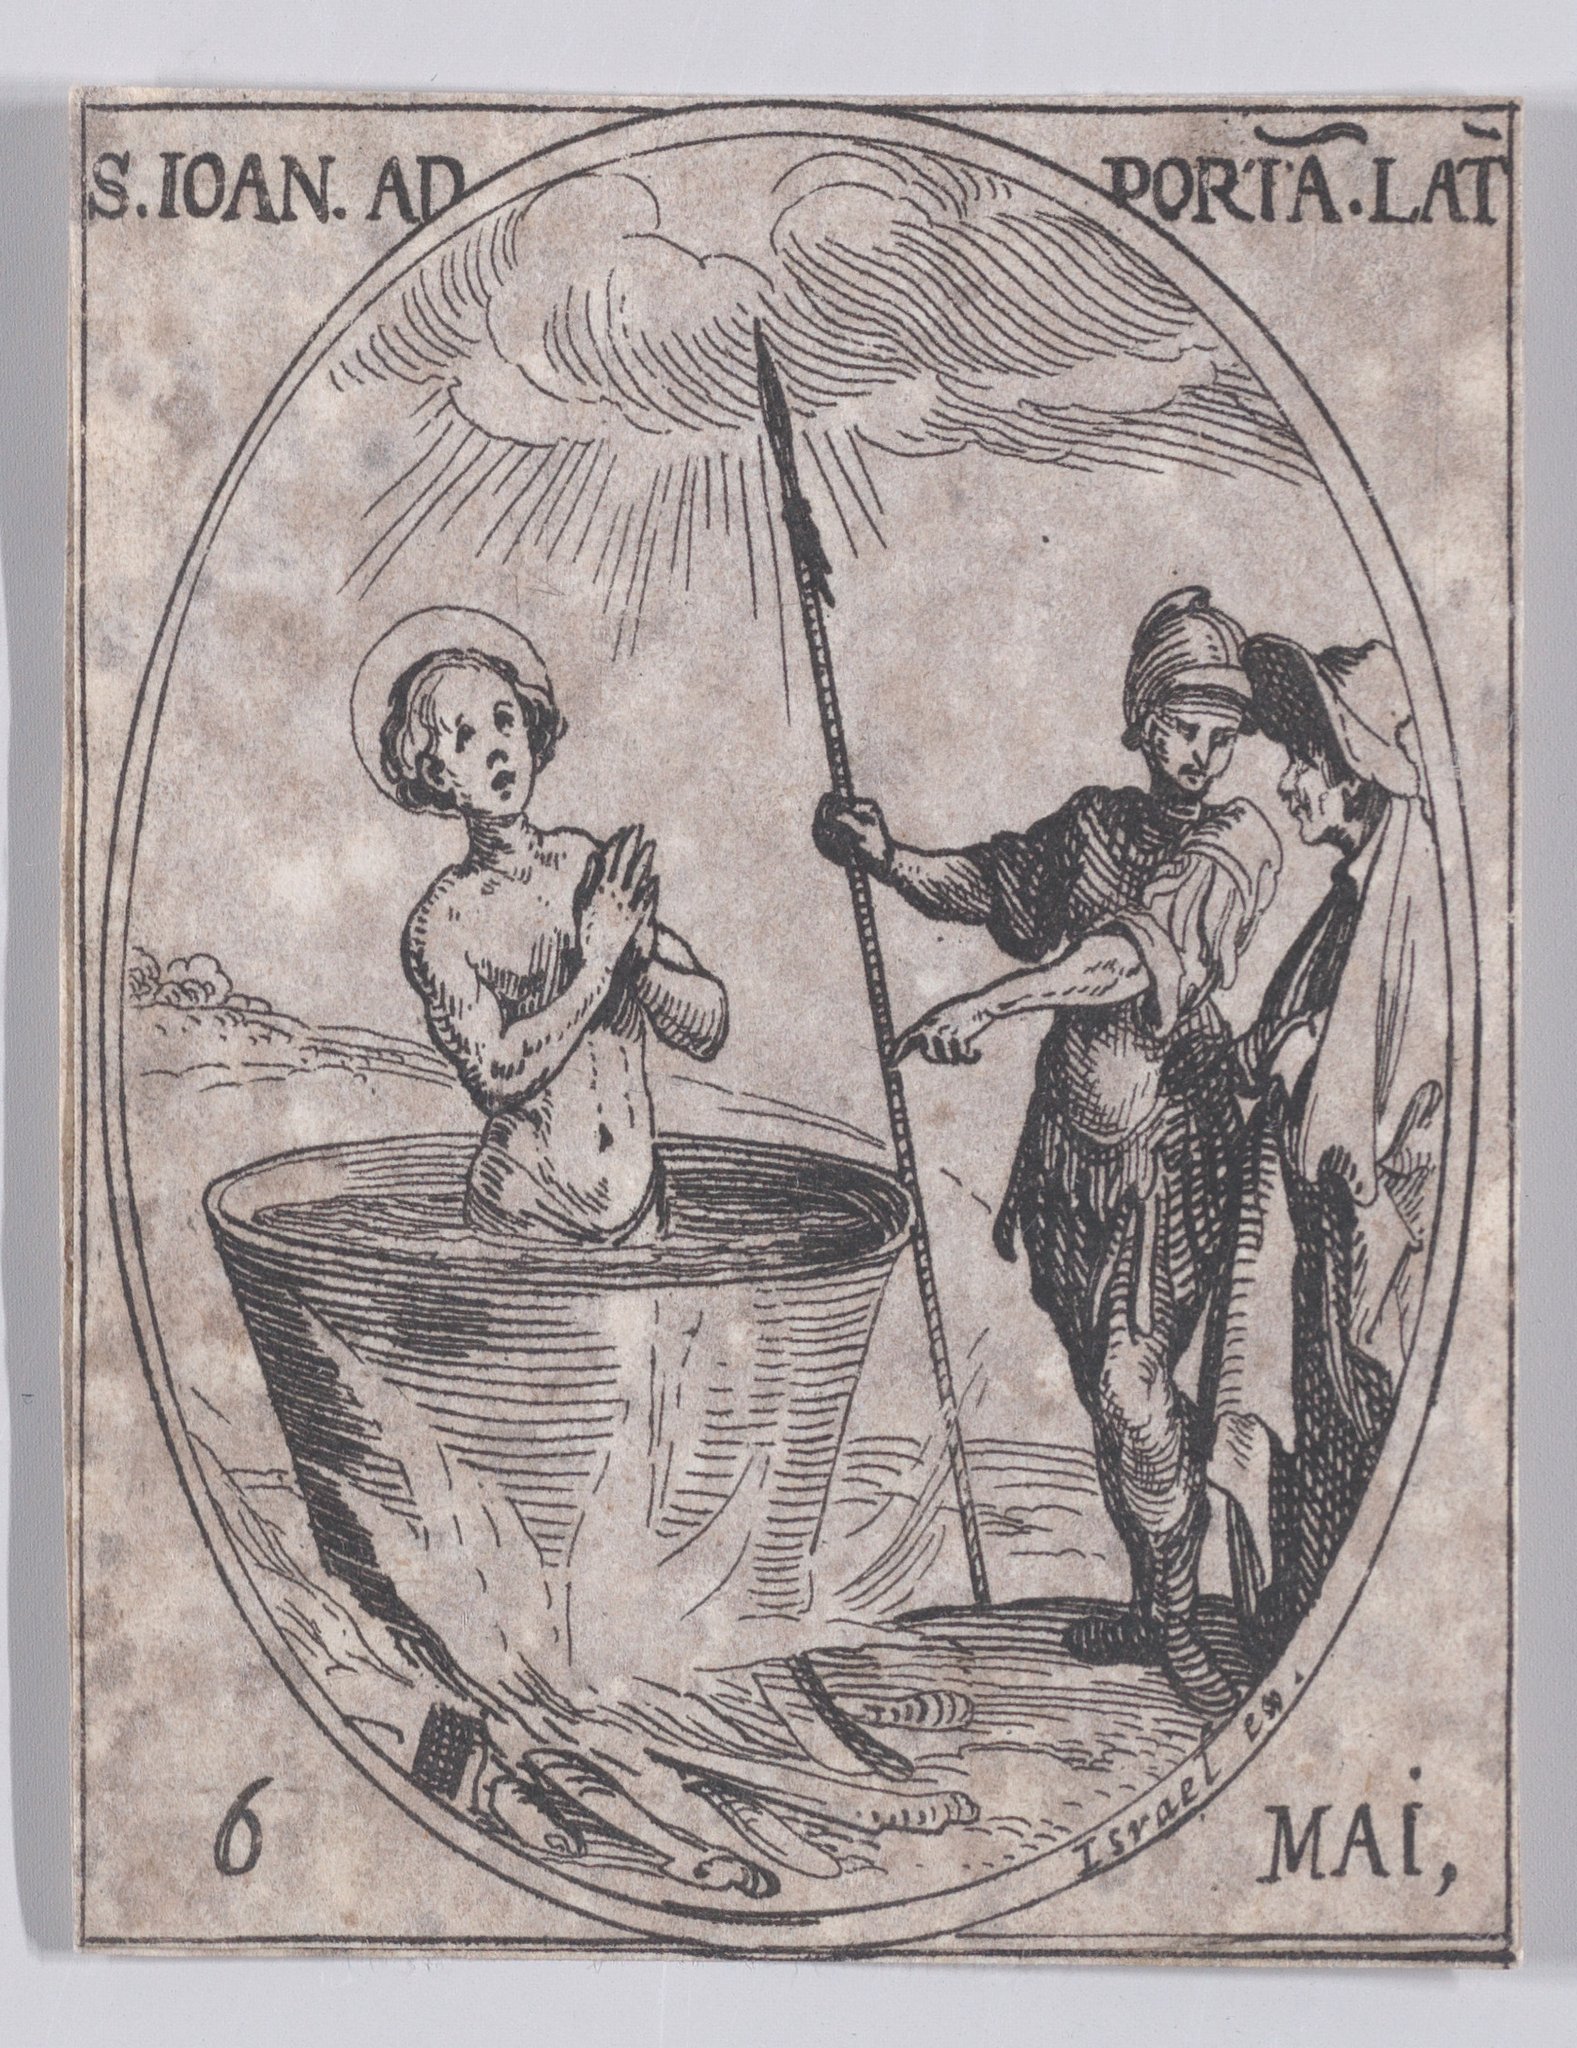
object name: print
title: S. Jean Devant la Porte Latine (St. John Before the Latin Gate), May 6th, from "Les Images De Tous Les Saincts et Saintes de L'Année" (Images of All of the Saints and Religious Events of the Year)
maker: jacques callot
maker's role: artist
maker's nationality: french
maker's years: 1592-1635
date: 1636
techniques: etching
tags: men,saints